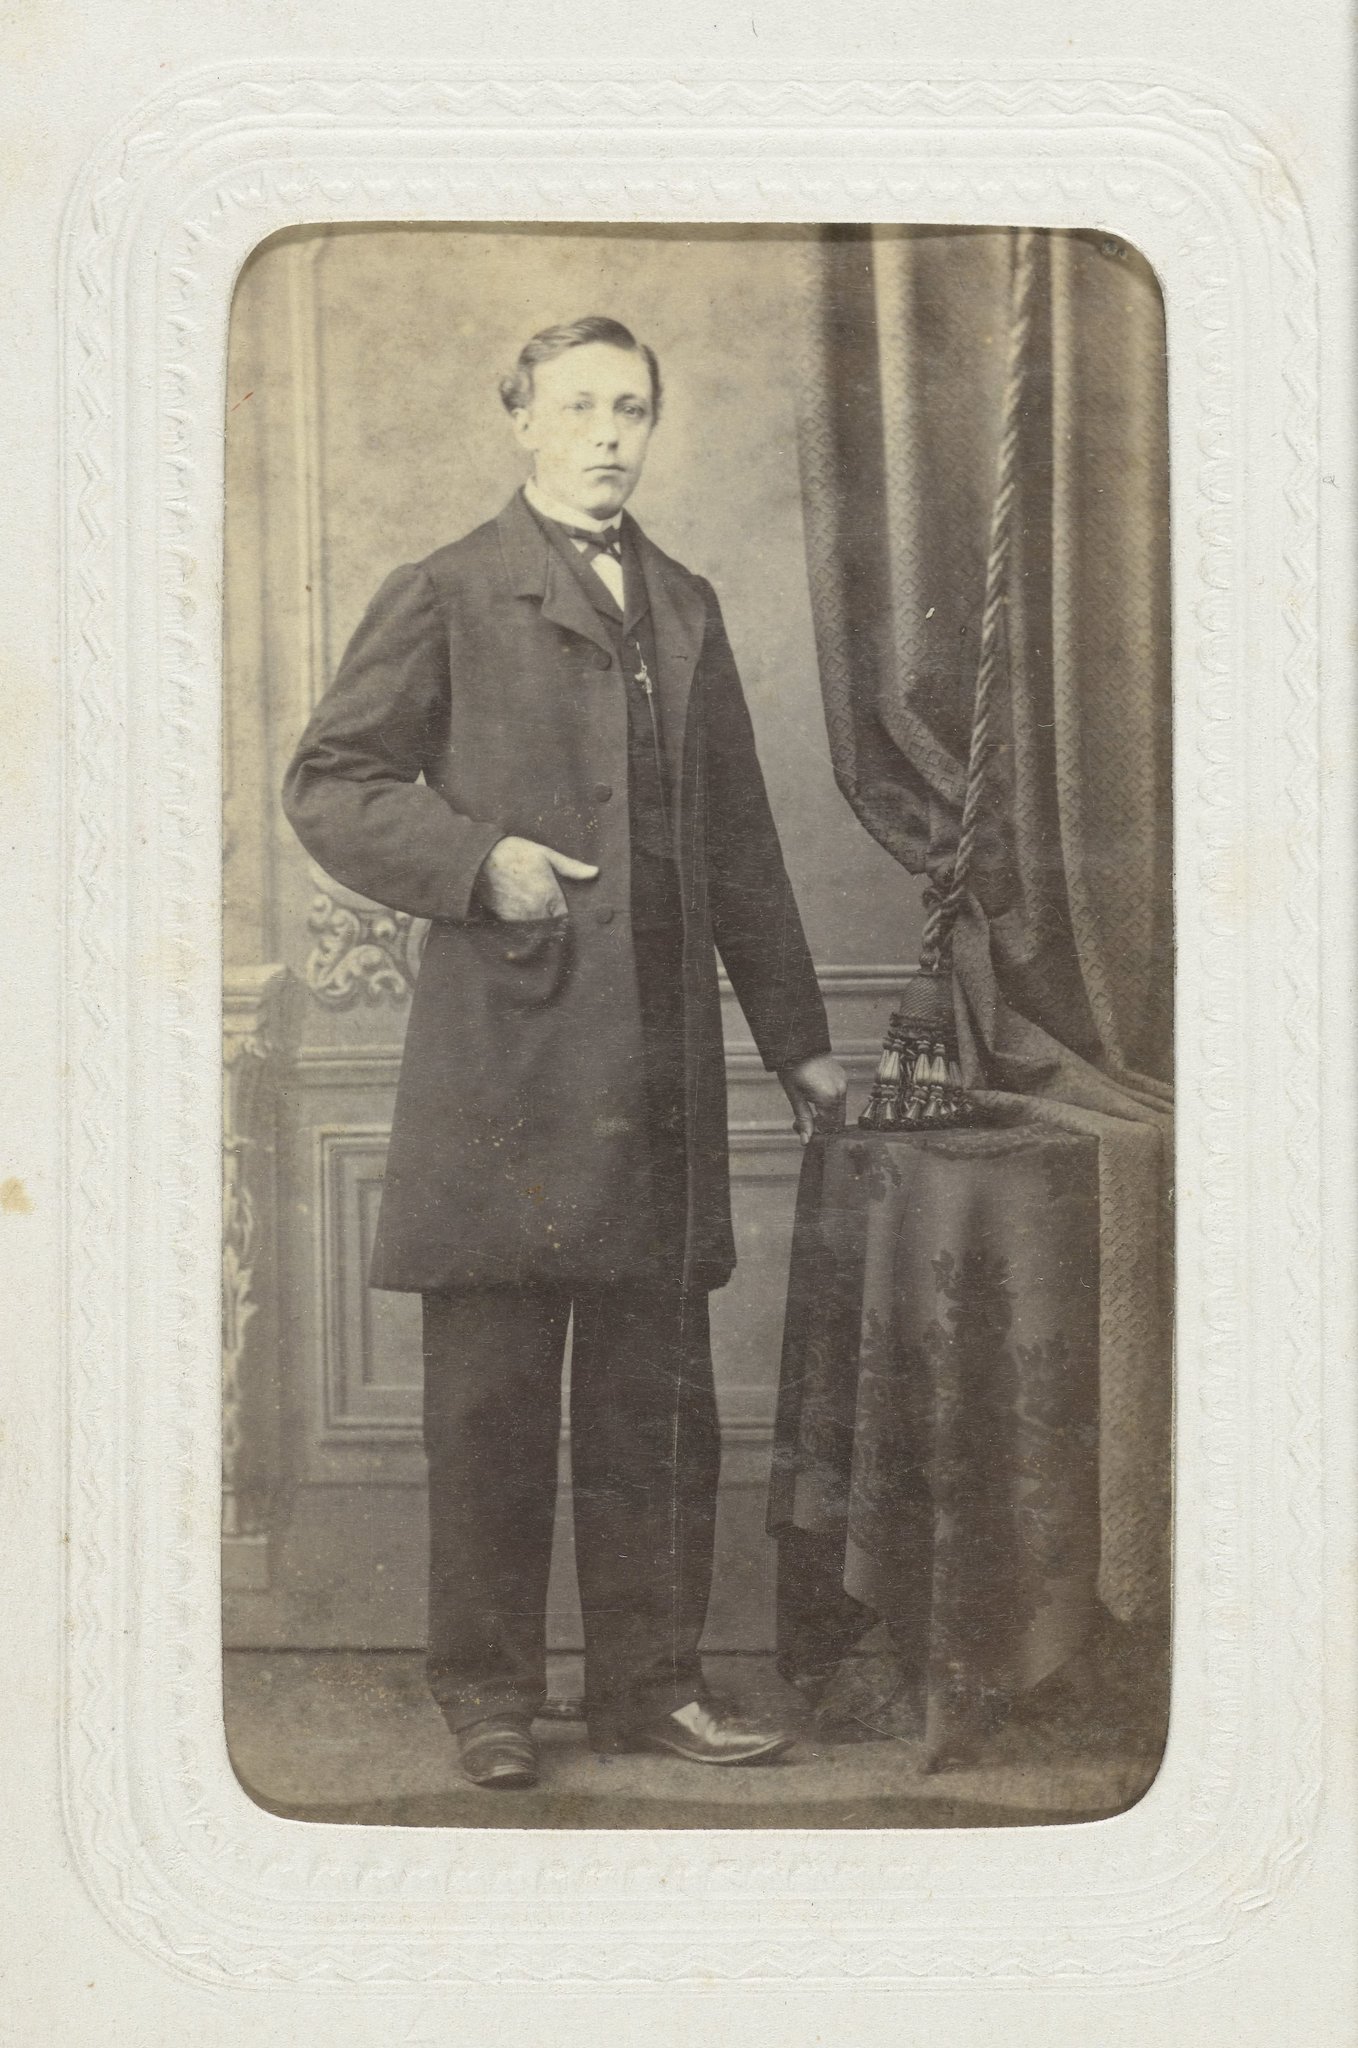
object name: carte de visite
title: Studioportret van een man staand aan tafel bij een achtergronddoek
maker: willem gerhardus kuijer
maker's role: fotograaf, hoffotograaf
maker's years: 1834-1899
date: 1863-1866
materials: cardboard, paper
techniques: albumen print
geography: amsterdam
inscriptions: name: ‘W.G. Kuijer Amsterdam’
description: De man draagt een lange jas en heeft zijn rechterhand in zijn jaszak.